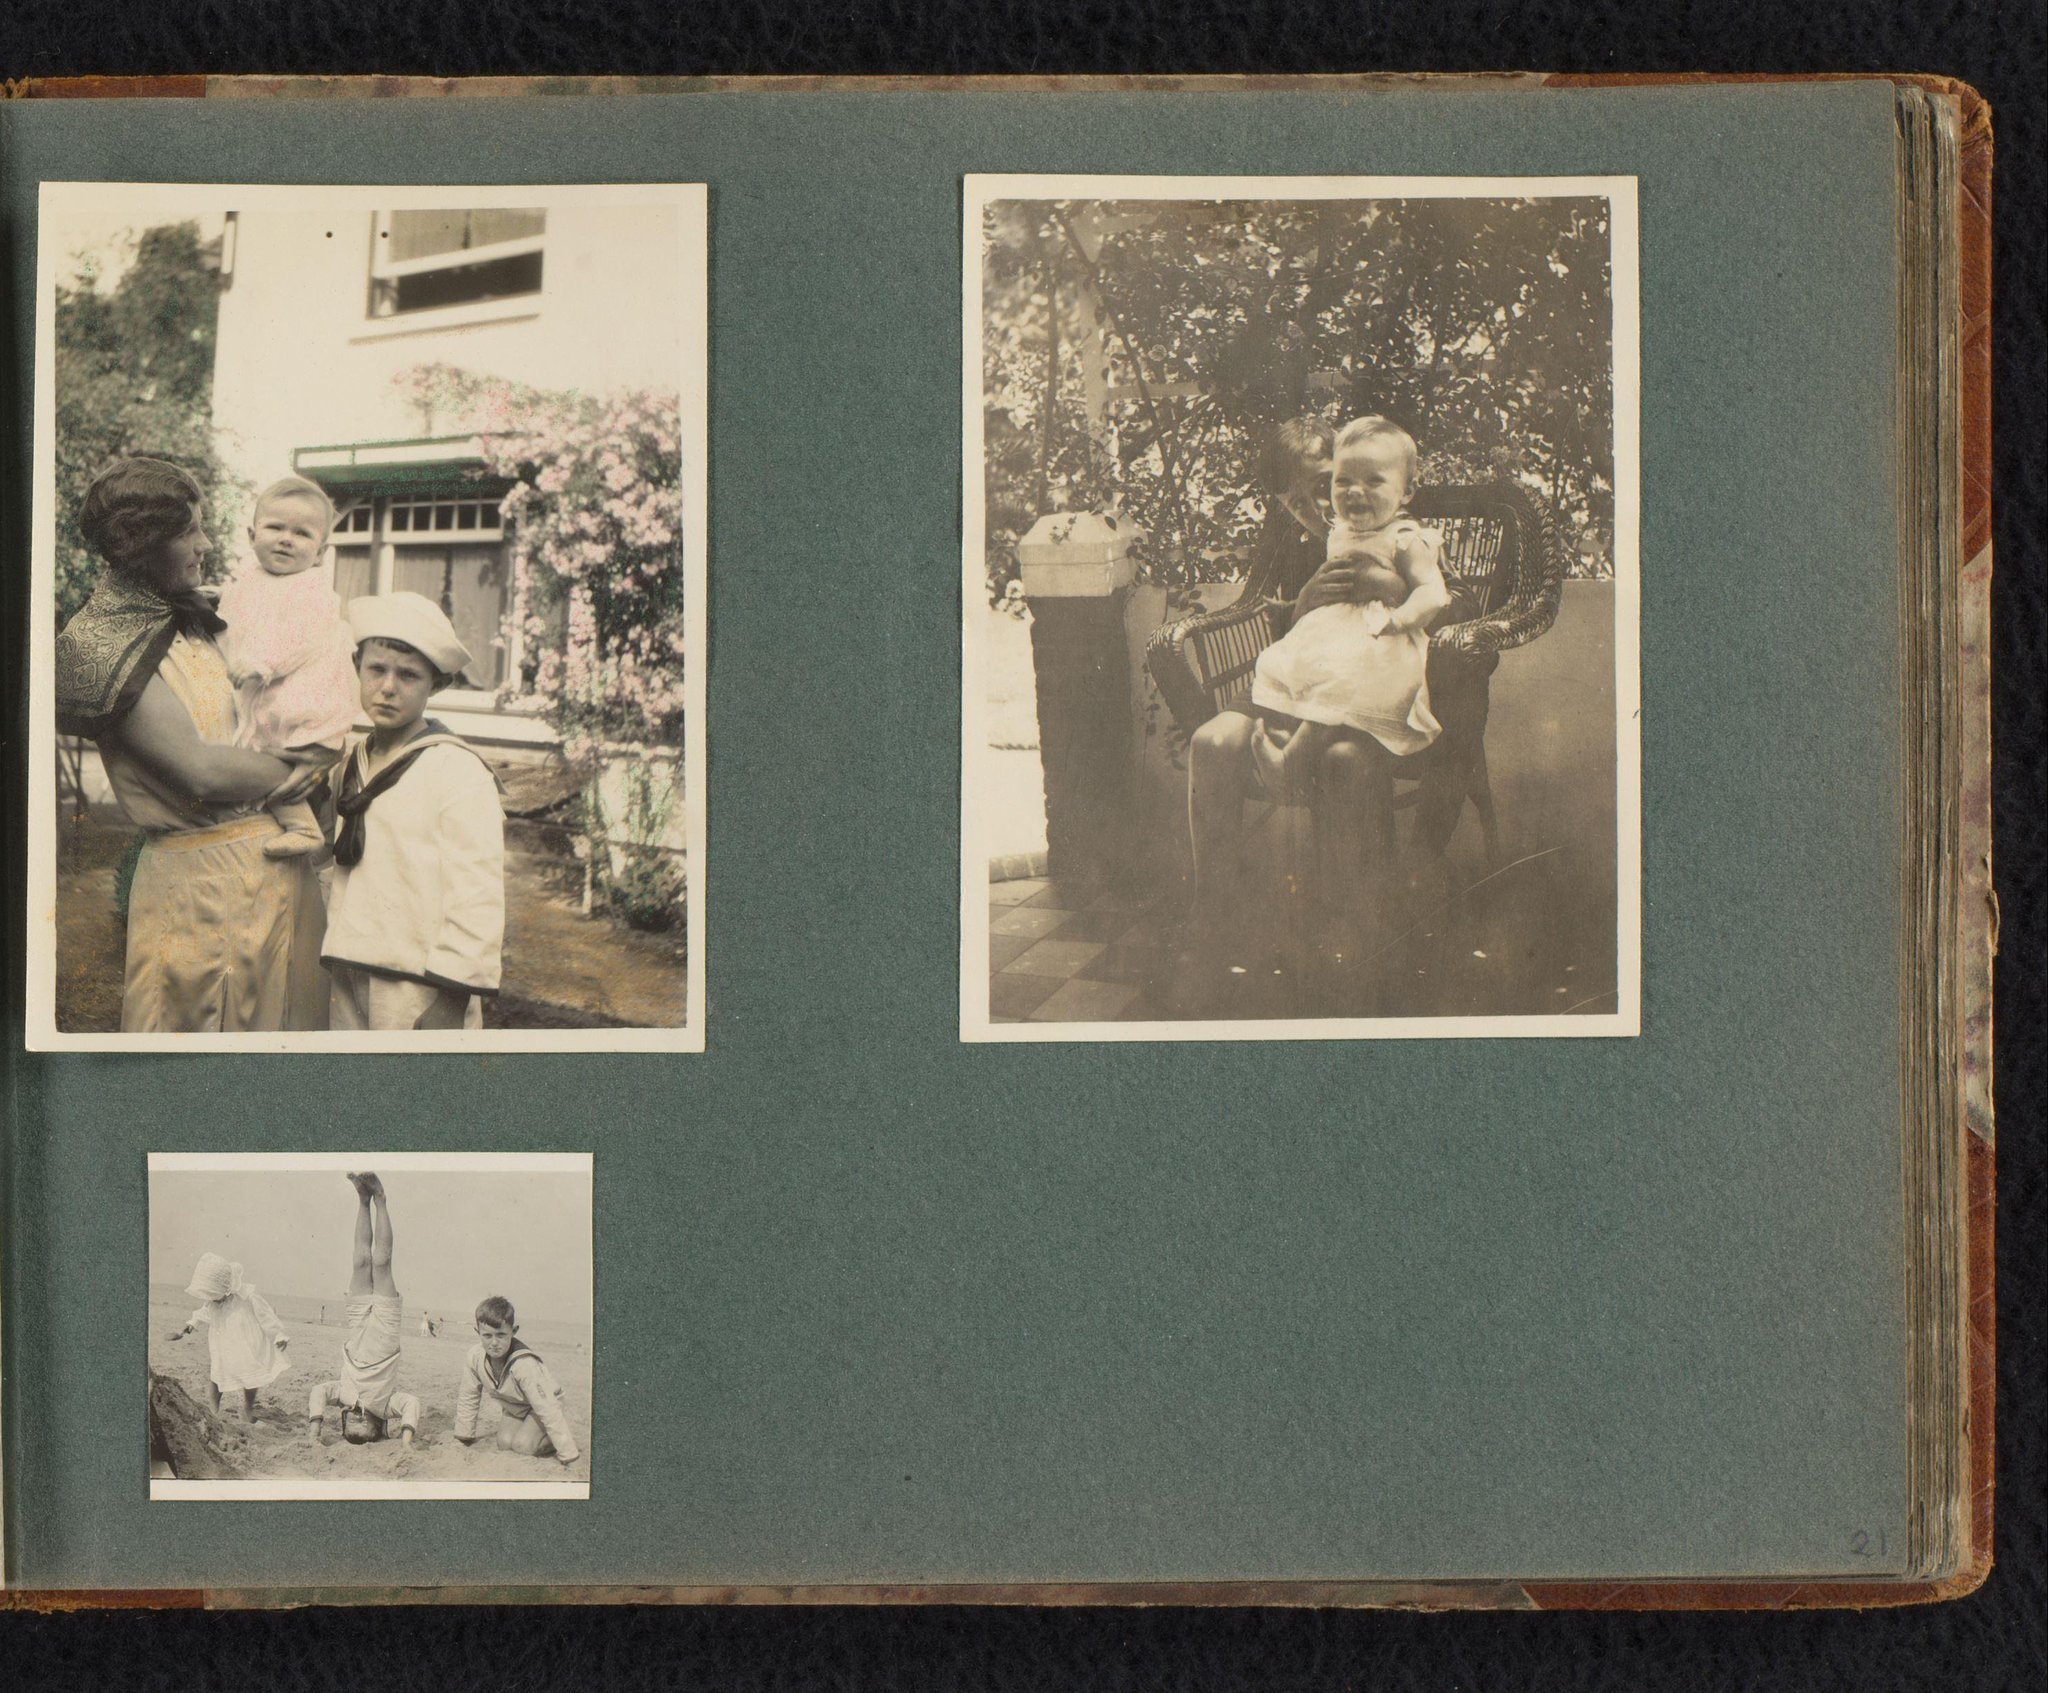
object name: album leaf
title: Drie foto's van Carolina Onnen, Frank Furnée en een ander kind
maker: Anonymous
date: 1920-1930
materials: paper, cardboard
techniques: gelatin silver print, hand coloring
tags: beach (as place of recreation), historical persons, family life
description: Deze foto's maken deel uit van een album.